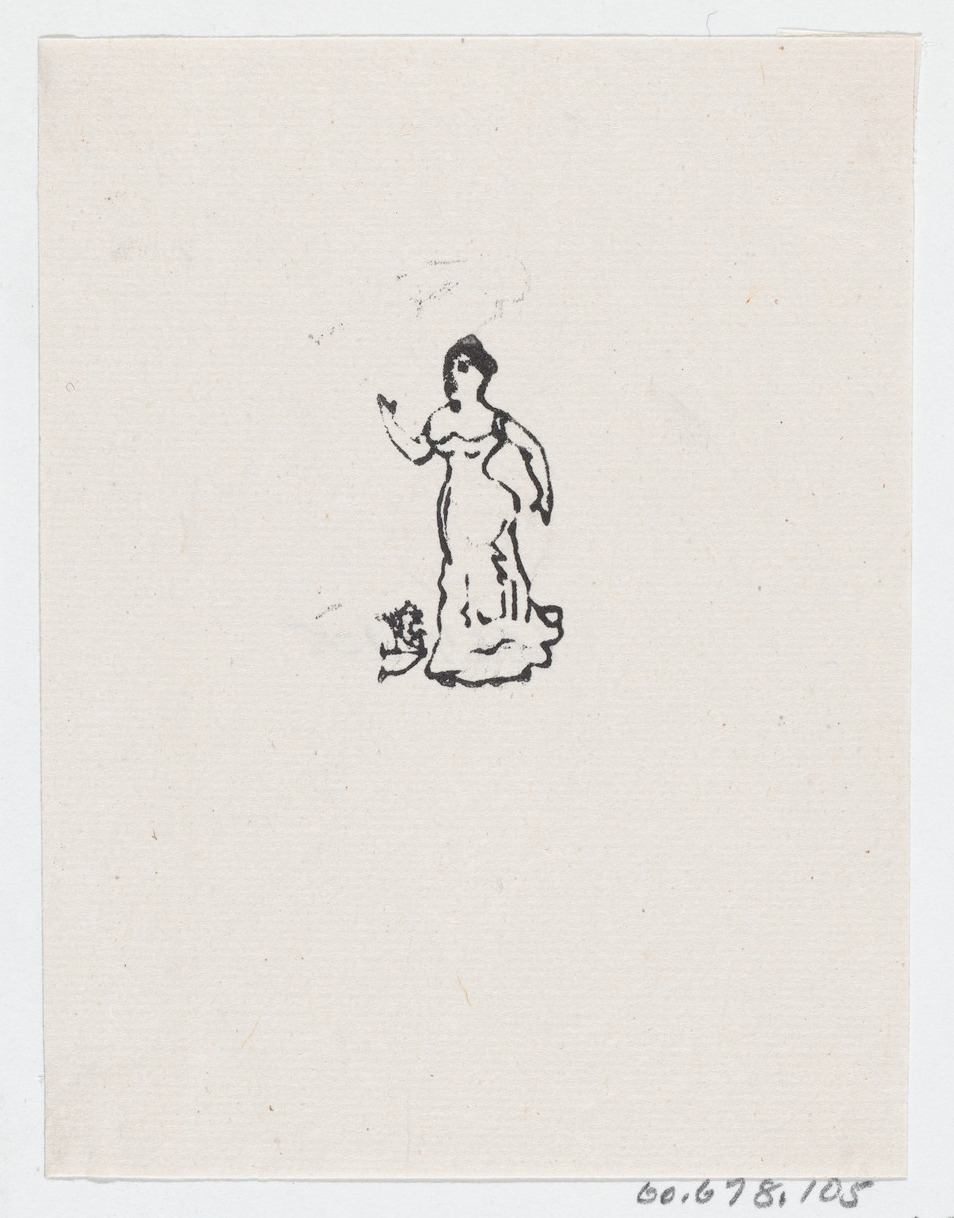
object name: print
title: A woman in an evening gown raising her right hand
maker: josé guadalupe posada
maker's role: artist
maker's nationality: mexican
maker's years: 1852-1913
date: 1880-1910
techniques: engraving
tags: women